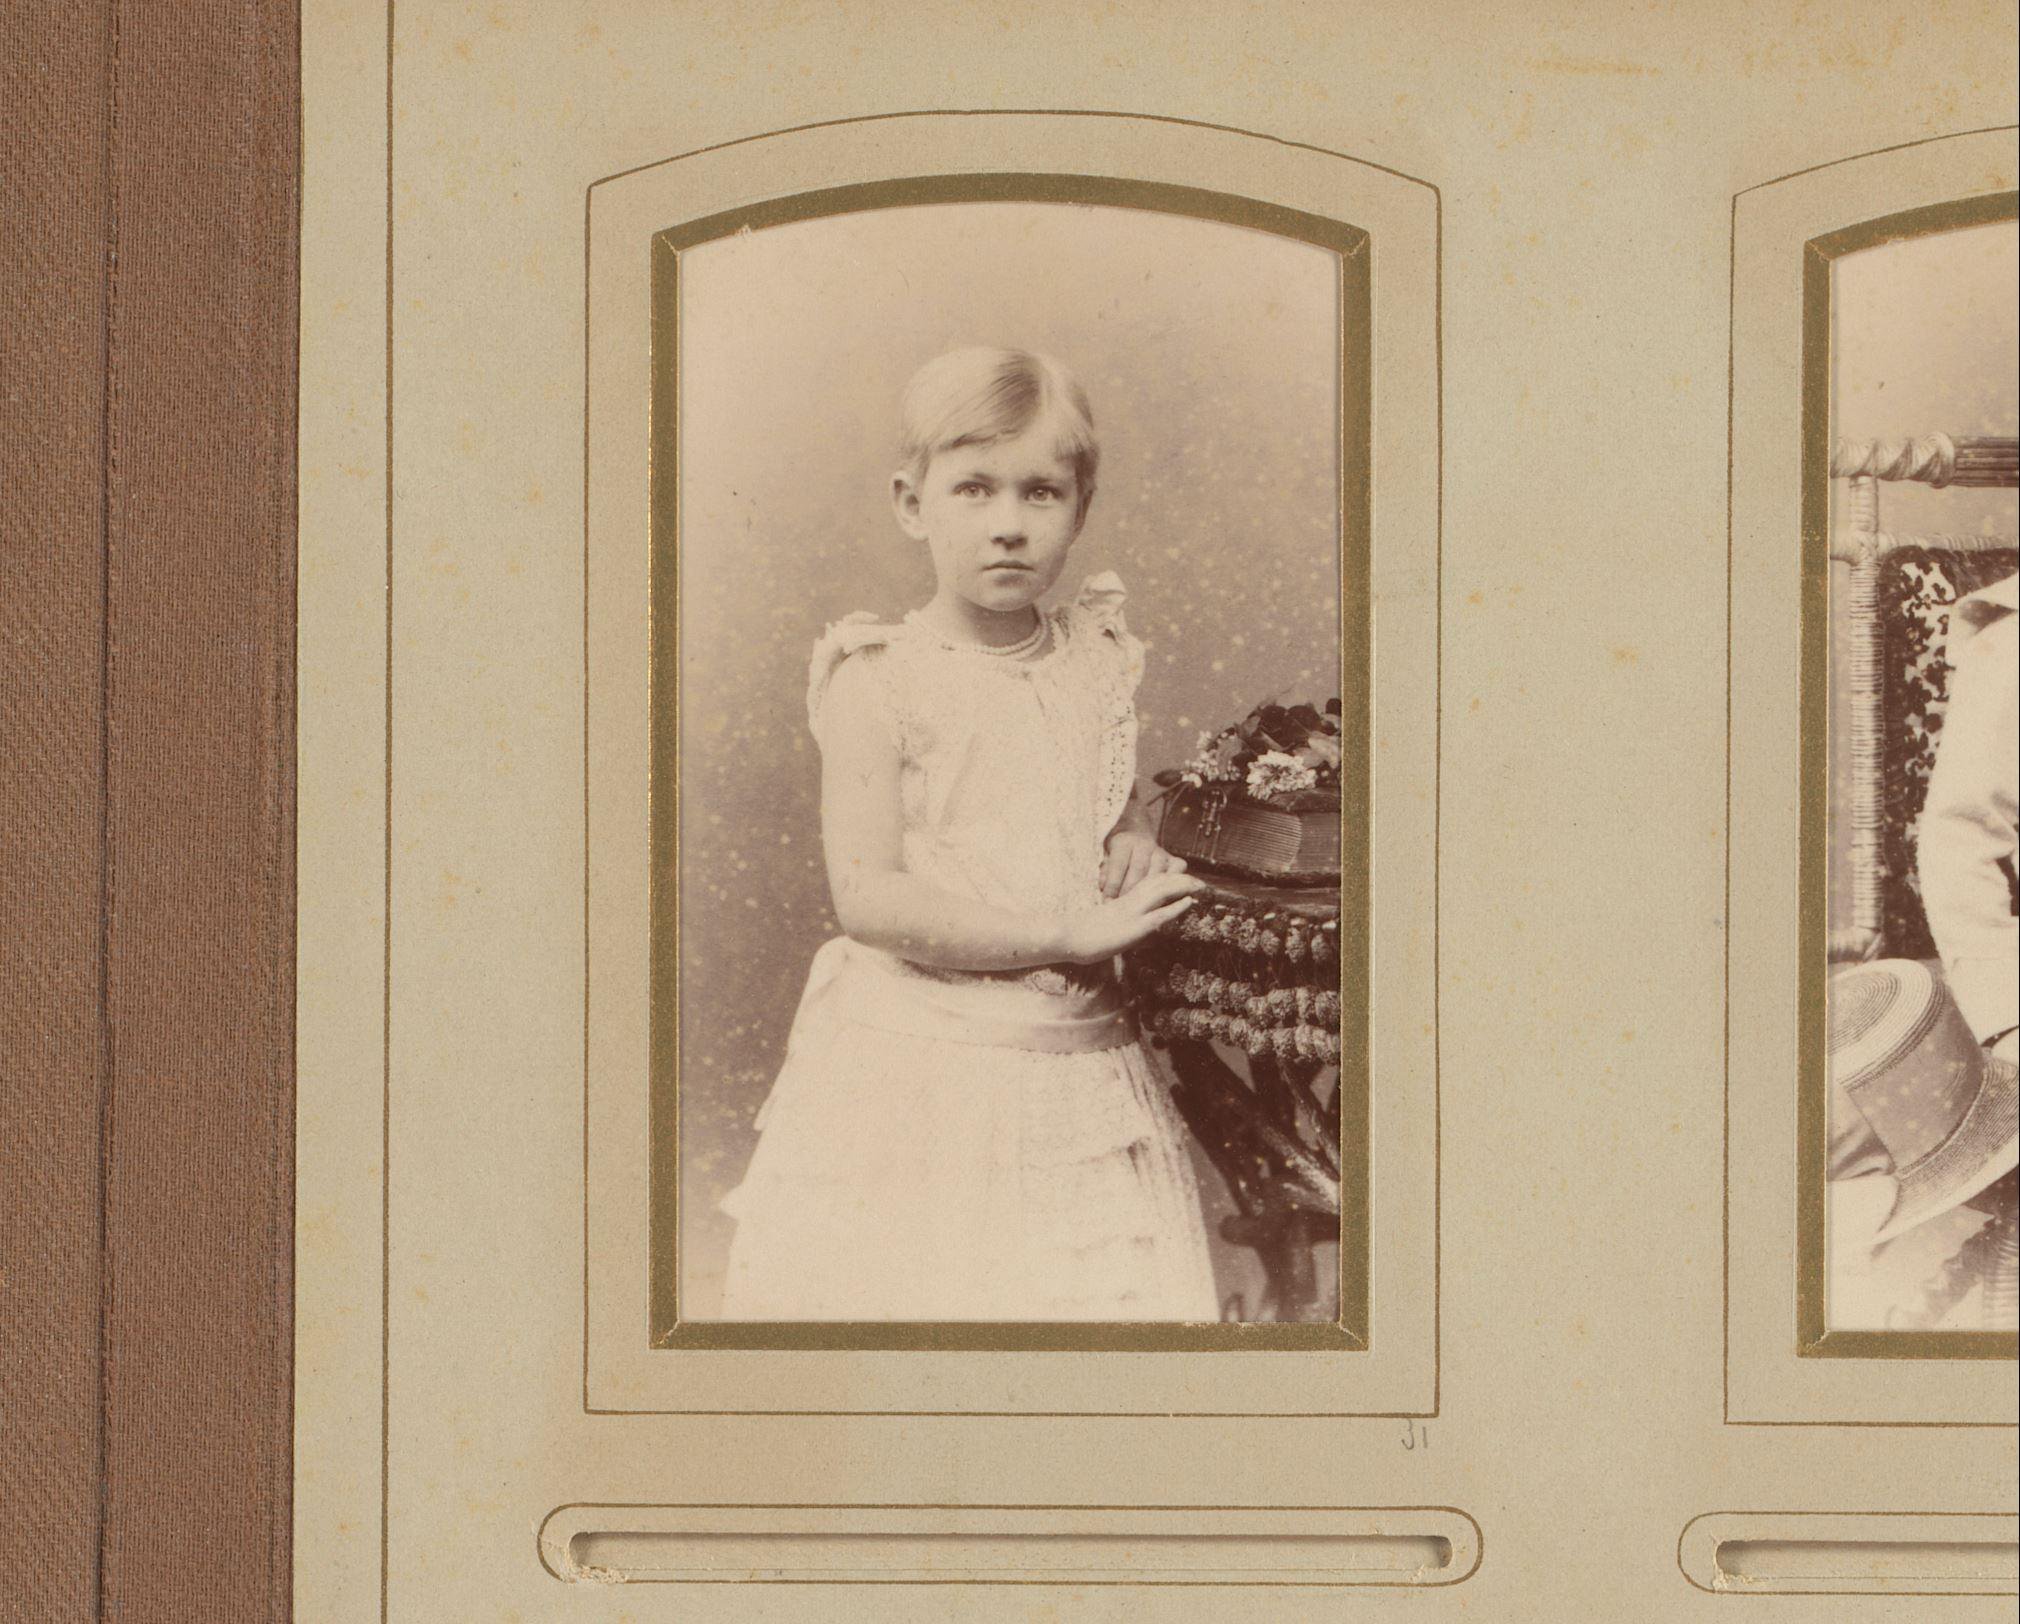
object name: carte de visite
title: Studioportret van An Kessler bij een tafel op jeugdige leeftijd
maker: kameke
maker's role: painter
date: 1889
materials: paper, photographic support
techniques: photography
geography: the hague